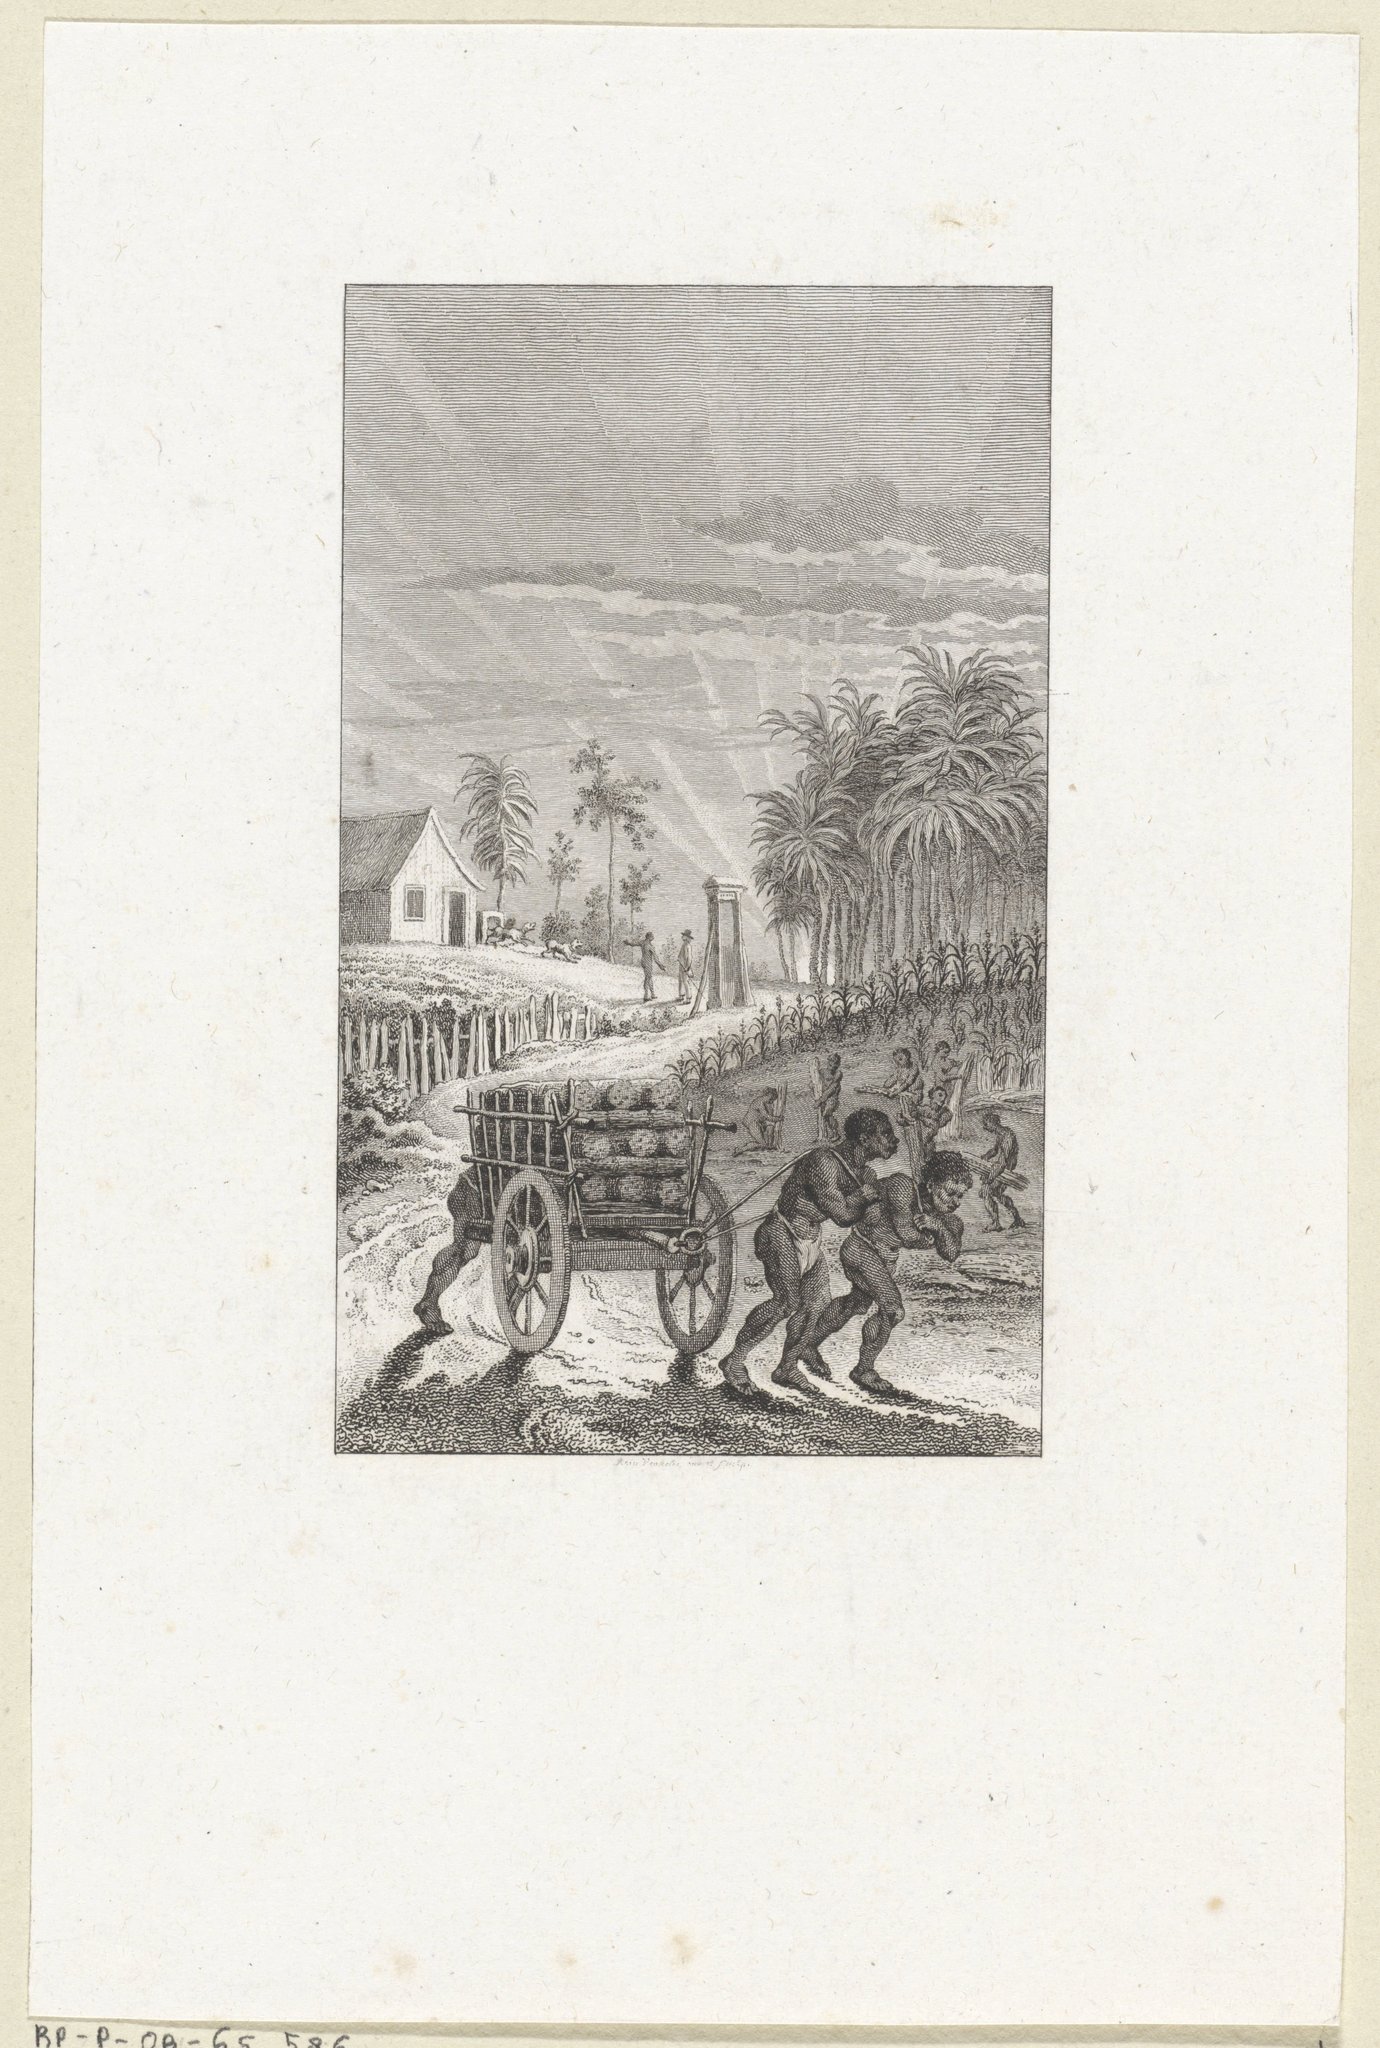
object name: print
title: Reinhart bij een suikerrietplantage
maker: reinier vinkeles (i)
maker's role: draughtsman, print maker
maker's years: 1741-1816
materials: paper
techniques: engraving, etching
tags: plantation, slavery; serfs and enslaved persons, dog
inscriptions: collector's mark: Lugt 240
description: Latere staat van prent gebruikt in: Post, Elisabeth Maria. Reinhart, of Natuur en Godsdienst. 3 dln. 1e druk. Amsterdam: Johannes Allart, 1791-1792, dl. 2 (1791), p. 319. En in: Post, Elisabeth Maria. Reinhart, of Natuur en Godsdienst. 3 dln. 2e druk. Amsterdam: Johannes Allart, 1798-1802, dl. 2 (1798), p. 319.